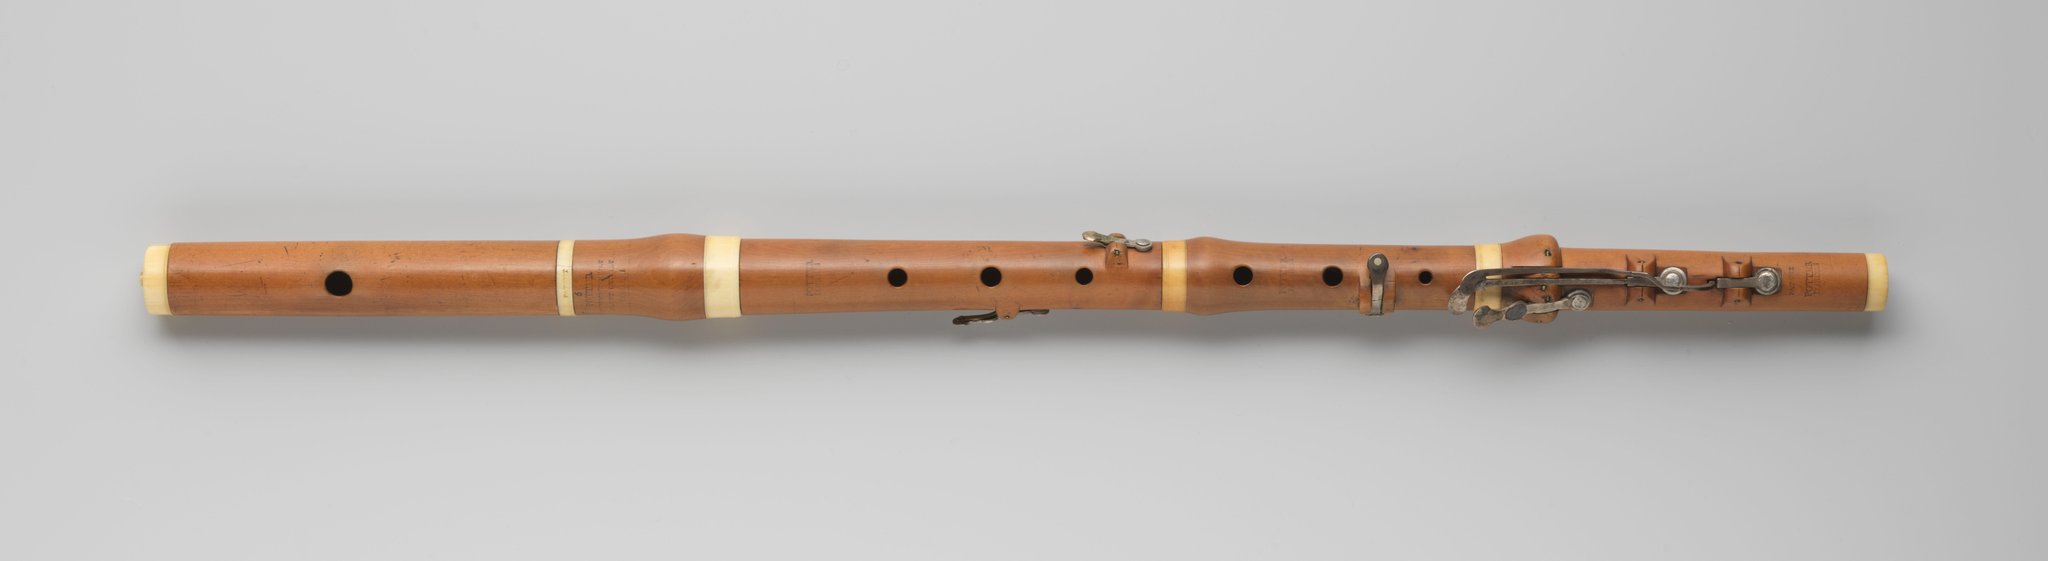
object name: flute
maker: richard potter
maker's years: 1726-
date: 1795-1800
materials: wood, ivory, metal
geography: london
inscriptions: stamp: ‘'POTTER / JOHNSON’S COURT / FLEET STREET / LONDON'’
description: Gaaf geconserveerde en nog uitstekend speelbare vierdelige dwarsfluit van buxushout met ringen van ivoor, gepatenteerde stemschuif (tuning slide) en zes metalen kleppen met klepvoeringen van tin. In originele doos; stemming ongeveer a-440 Hz. Stempel: 'POTTER / JOHNSON’S COURT / FLEET STREET / LONDON'.